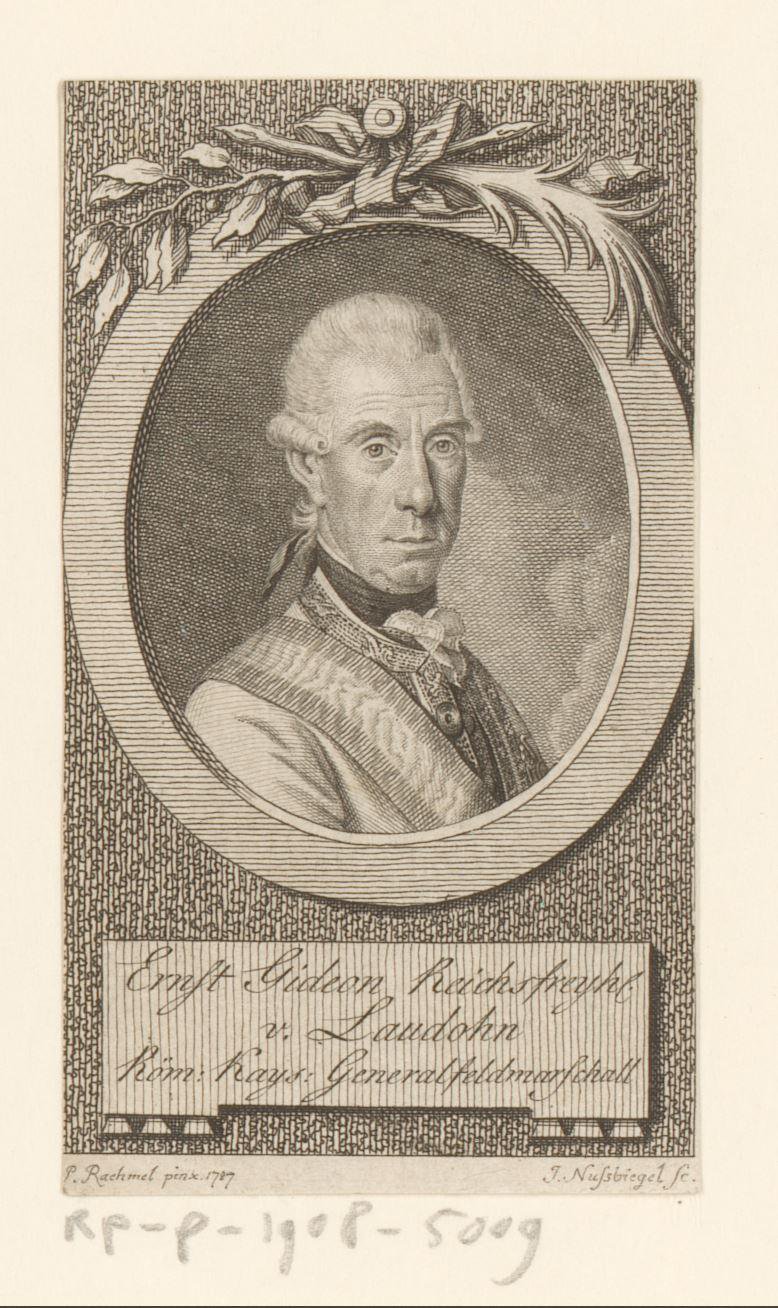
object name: print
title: Portret van Gideon Ernst von Laudon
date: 1787-1829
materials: paper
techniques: engraving, etching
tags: historical persons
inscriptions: collector's mark: Lugt 2228